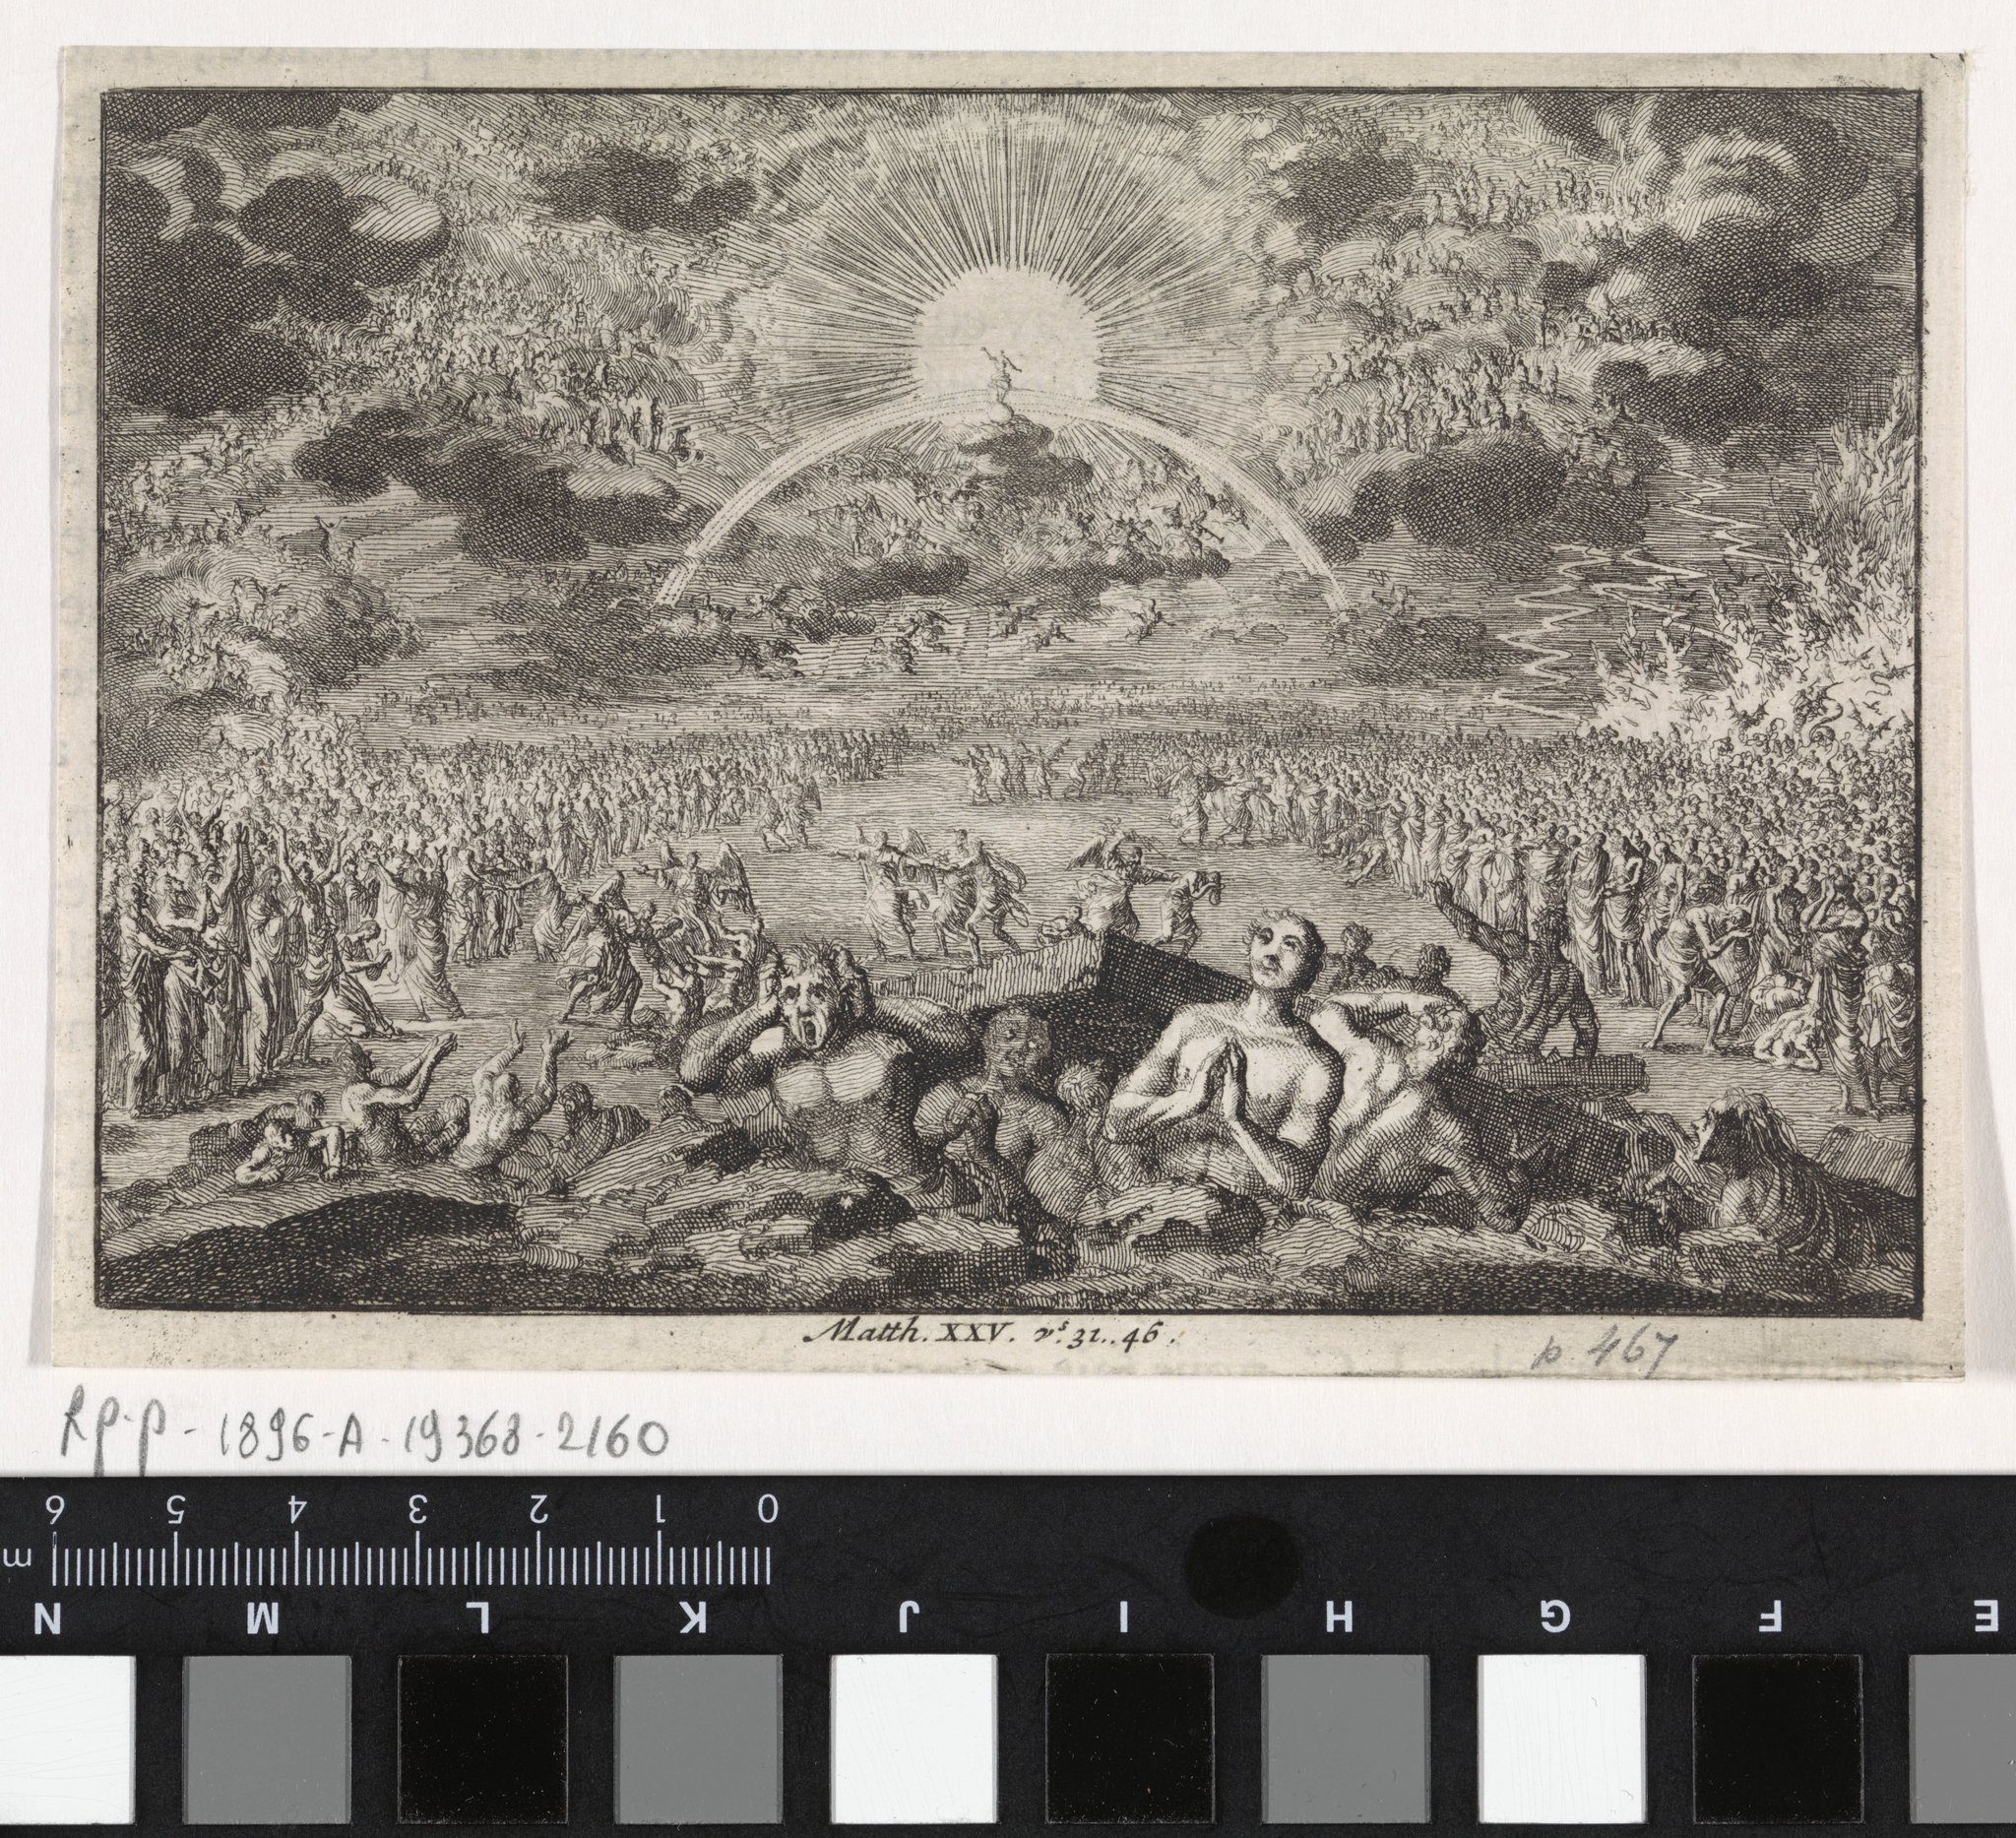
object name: print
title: Laatste oordeel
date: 1703-1762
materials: paper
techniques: etching, letterpress printing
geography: amsterdam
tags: comprehensive representation of last judgement: christ (with sword and lily), often surrounded by elders and sometimes accompanied by mary and john the baptist, appears in the sky with trumpeting angels (and sometimes angels holding the instruments of the passion); after the resurrection of the dead the blessed are led to heaven by angels, and the damned are dragged into hell by devils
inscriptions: collector's mark: Lugt 2228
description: De prent komt een eerste keer voor als boekillustratie voor David Martin. Historie des Ouden en Nieuwen Testaments. Amsterdam, Pieter Mortier, 1703. Deel II. De boekillustraties voor de Mortierbijbel hebben verschillende staten en kopieën, waarbij de chronologische volgorde moeilijk te achterhalen valt. Als boekillustraties werden ze bovendien herhaaldelijk opnieuw gebruikt voor andere boekwerken.